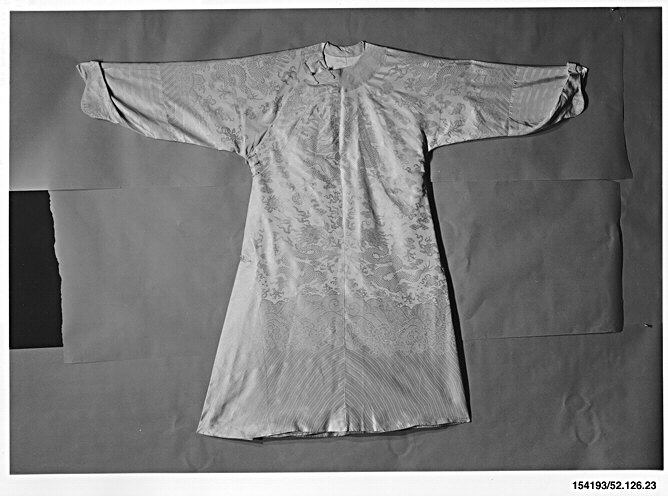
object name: dragon robe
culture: chinese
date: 1867-1900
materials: silk